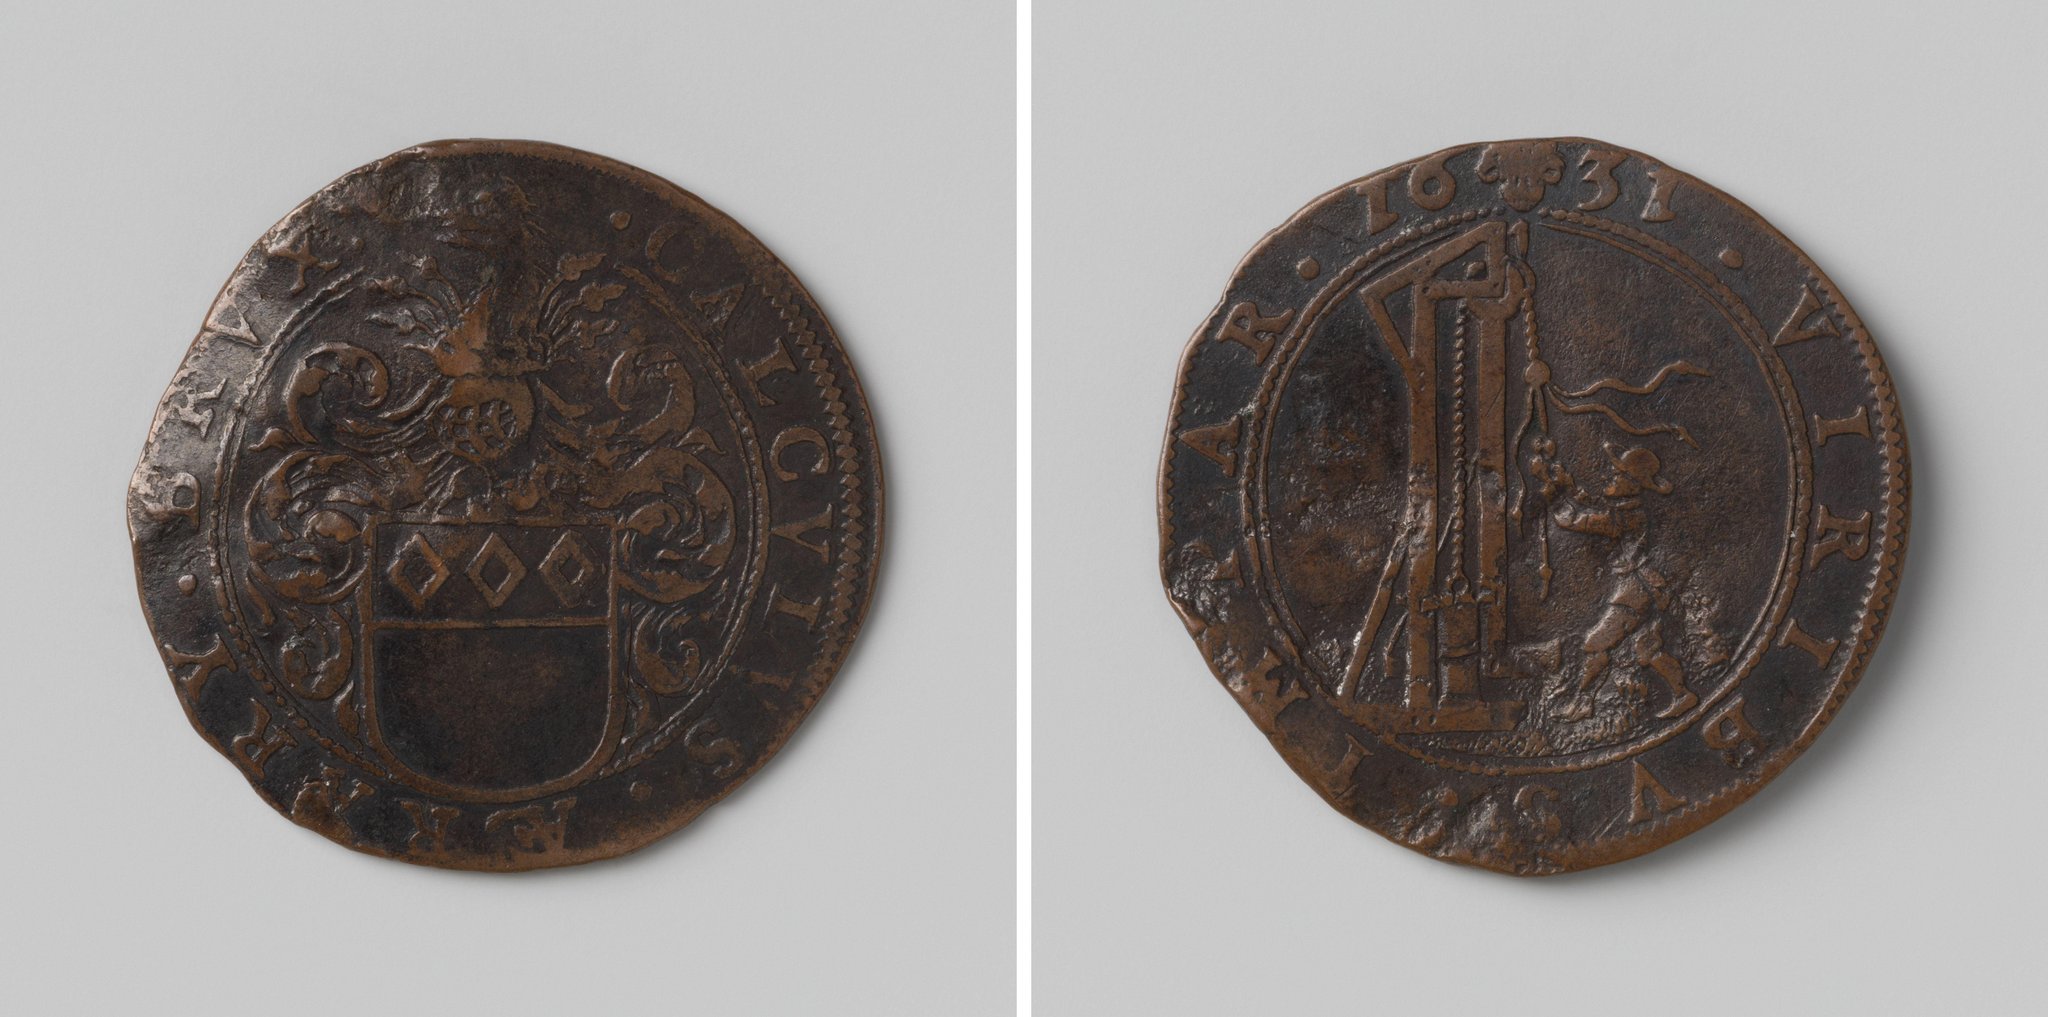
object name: jeton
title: Claude van der Eycken, magistraat van de schatkist van Brussel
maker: Anonymous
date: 1601-1631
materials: copper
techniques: striking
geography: brussels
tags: brussels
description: Koperen penning. Voorzijde: gehelmd wapenschild binnen omschrift. Keerzijde: man, trekkend aan touw van hijwerktuig binnen omschrift